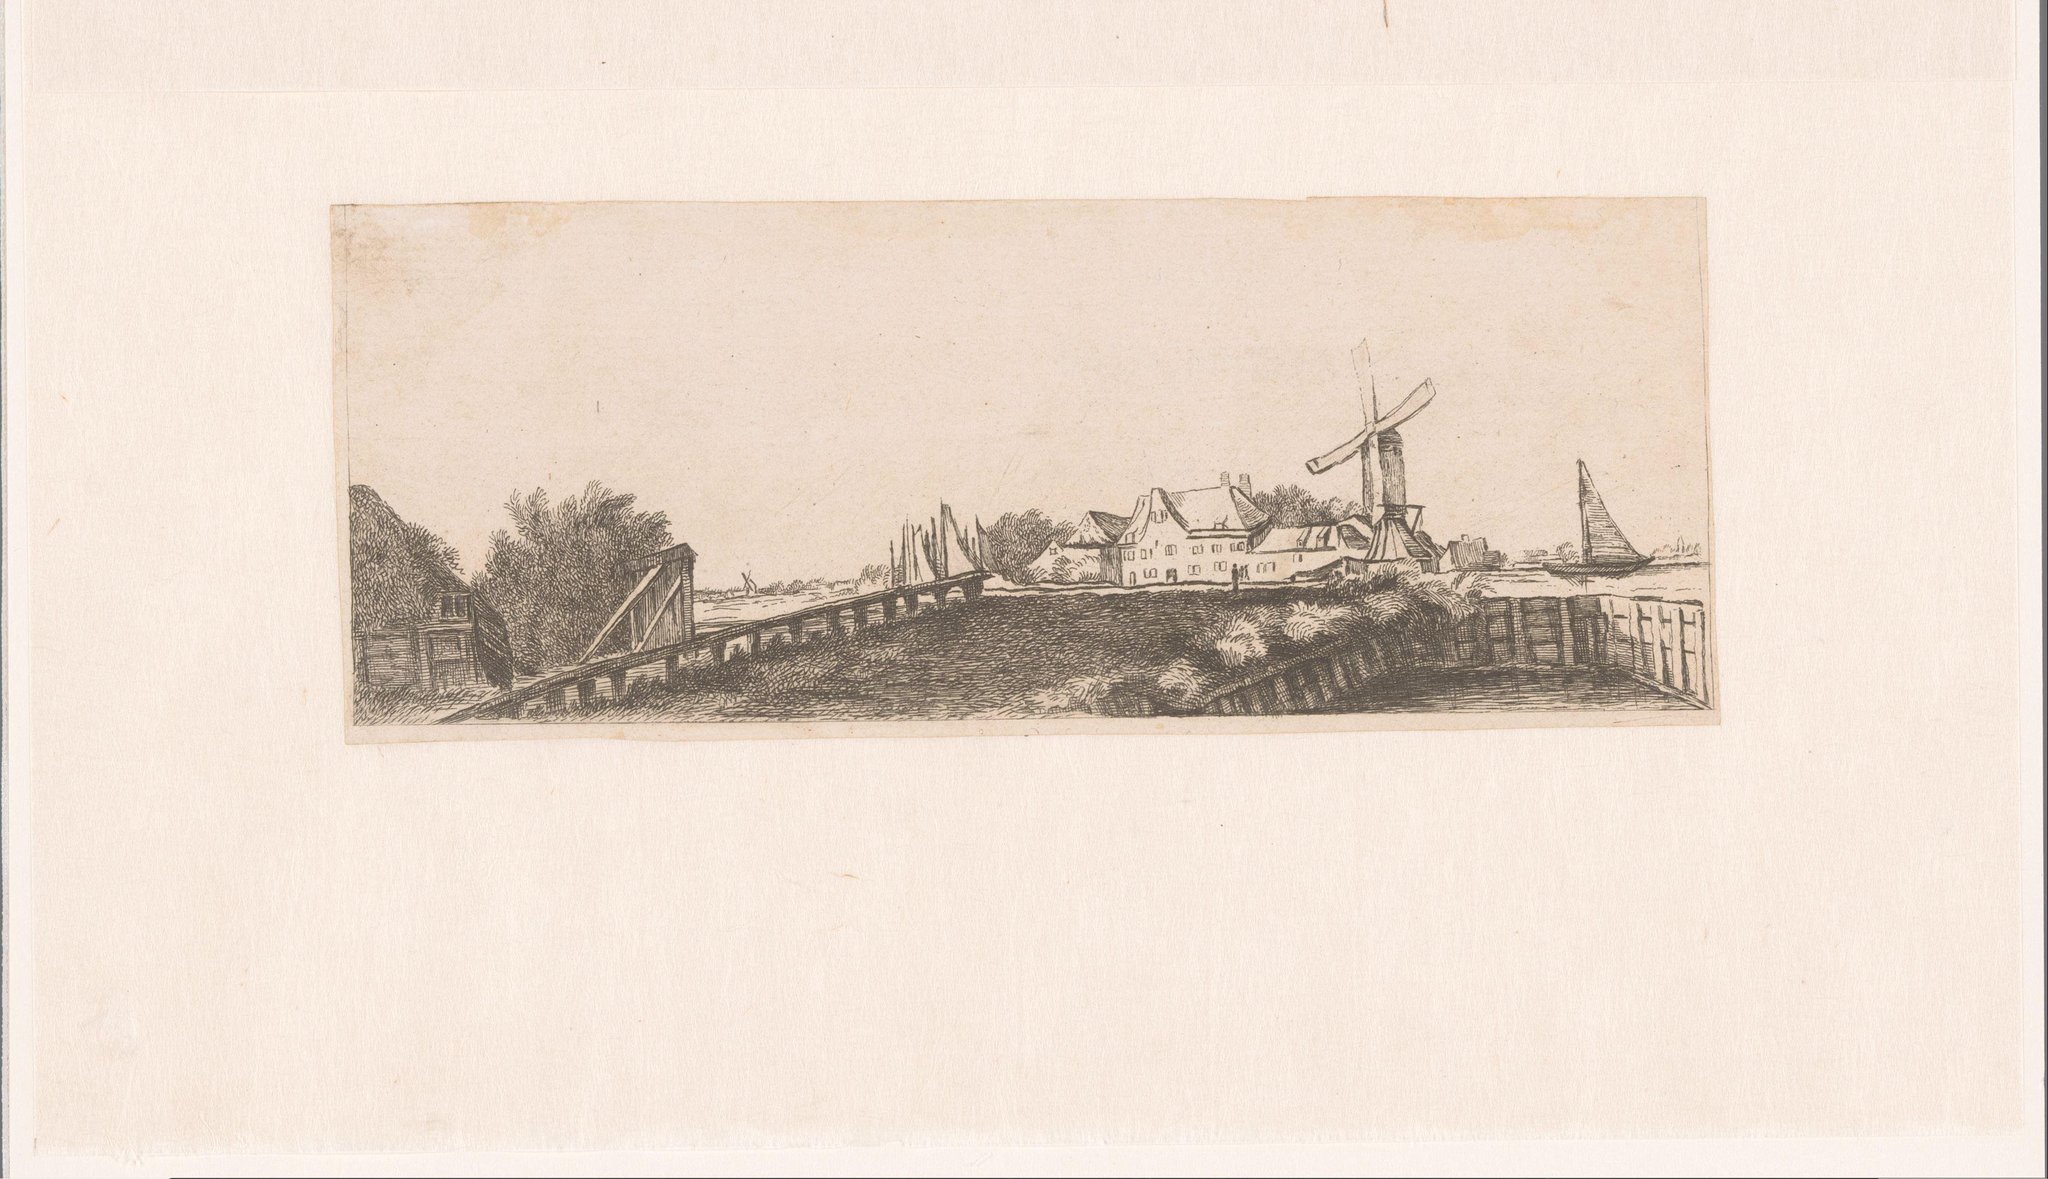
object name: print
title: Landschap met houten brug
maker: pierre françois basan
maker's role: print maker, publisher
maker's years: 1723-1797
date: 1750-1797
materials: paper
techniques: etching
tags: landscapes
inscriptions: collector's mark: Lugt 2228, collector's mark: Lugt 2434, collector's mark: Lugt 4071, collector's mark: Lugt 1606, collector's mark: Lugt 2760, collector's mark: Lugt 2482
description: Prent voor het eerst gebruikt in: Recueil de Quatre-Vingt-Cinq estampes originales, têtes, paysages et différens sujets, dessinées et gravées par Rembrandt. Parijs: Henry Louis Basan, 1819.